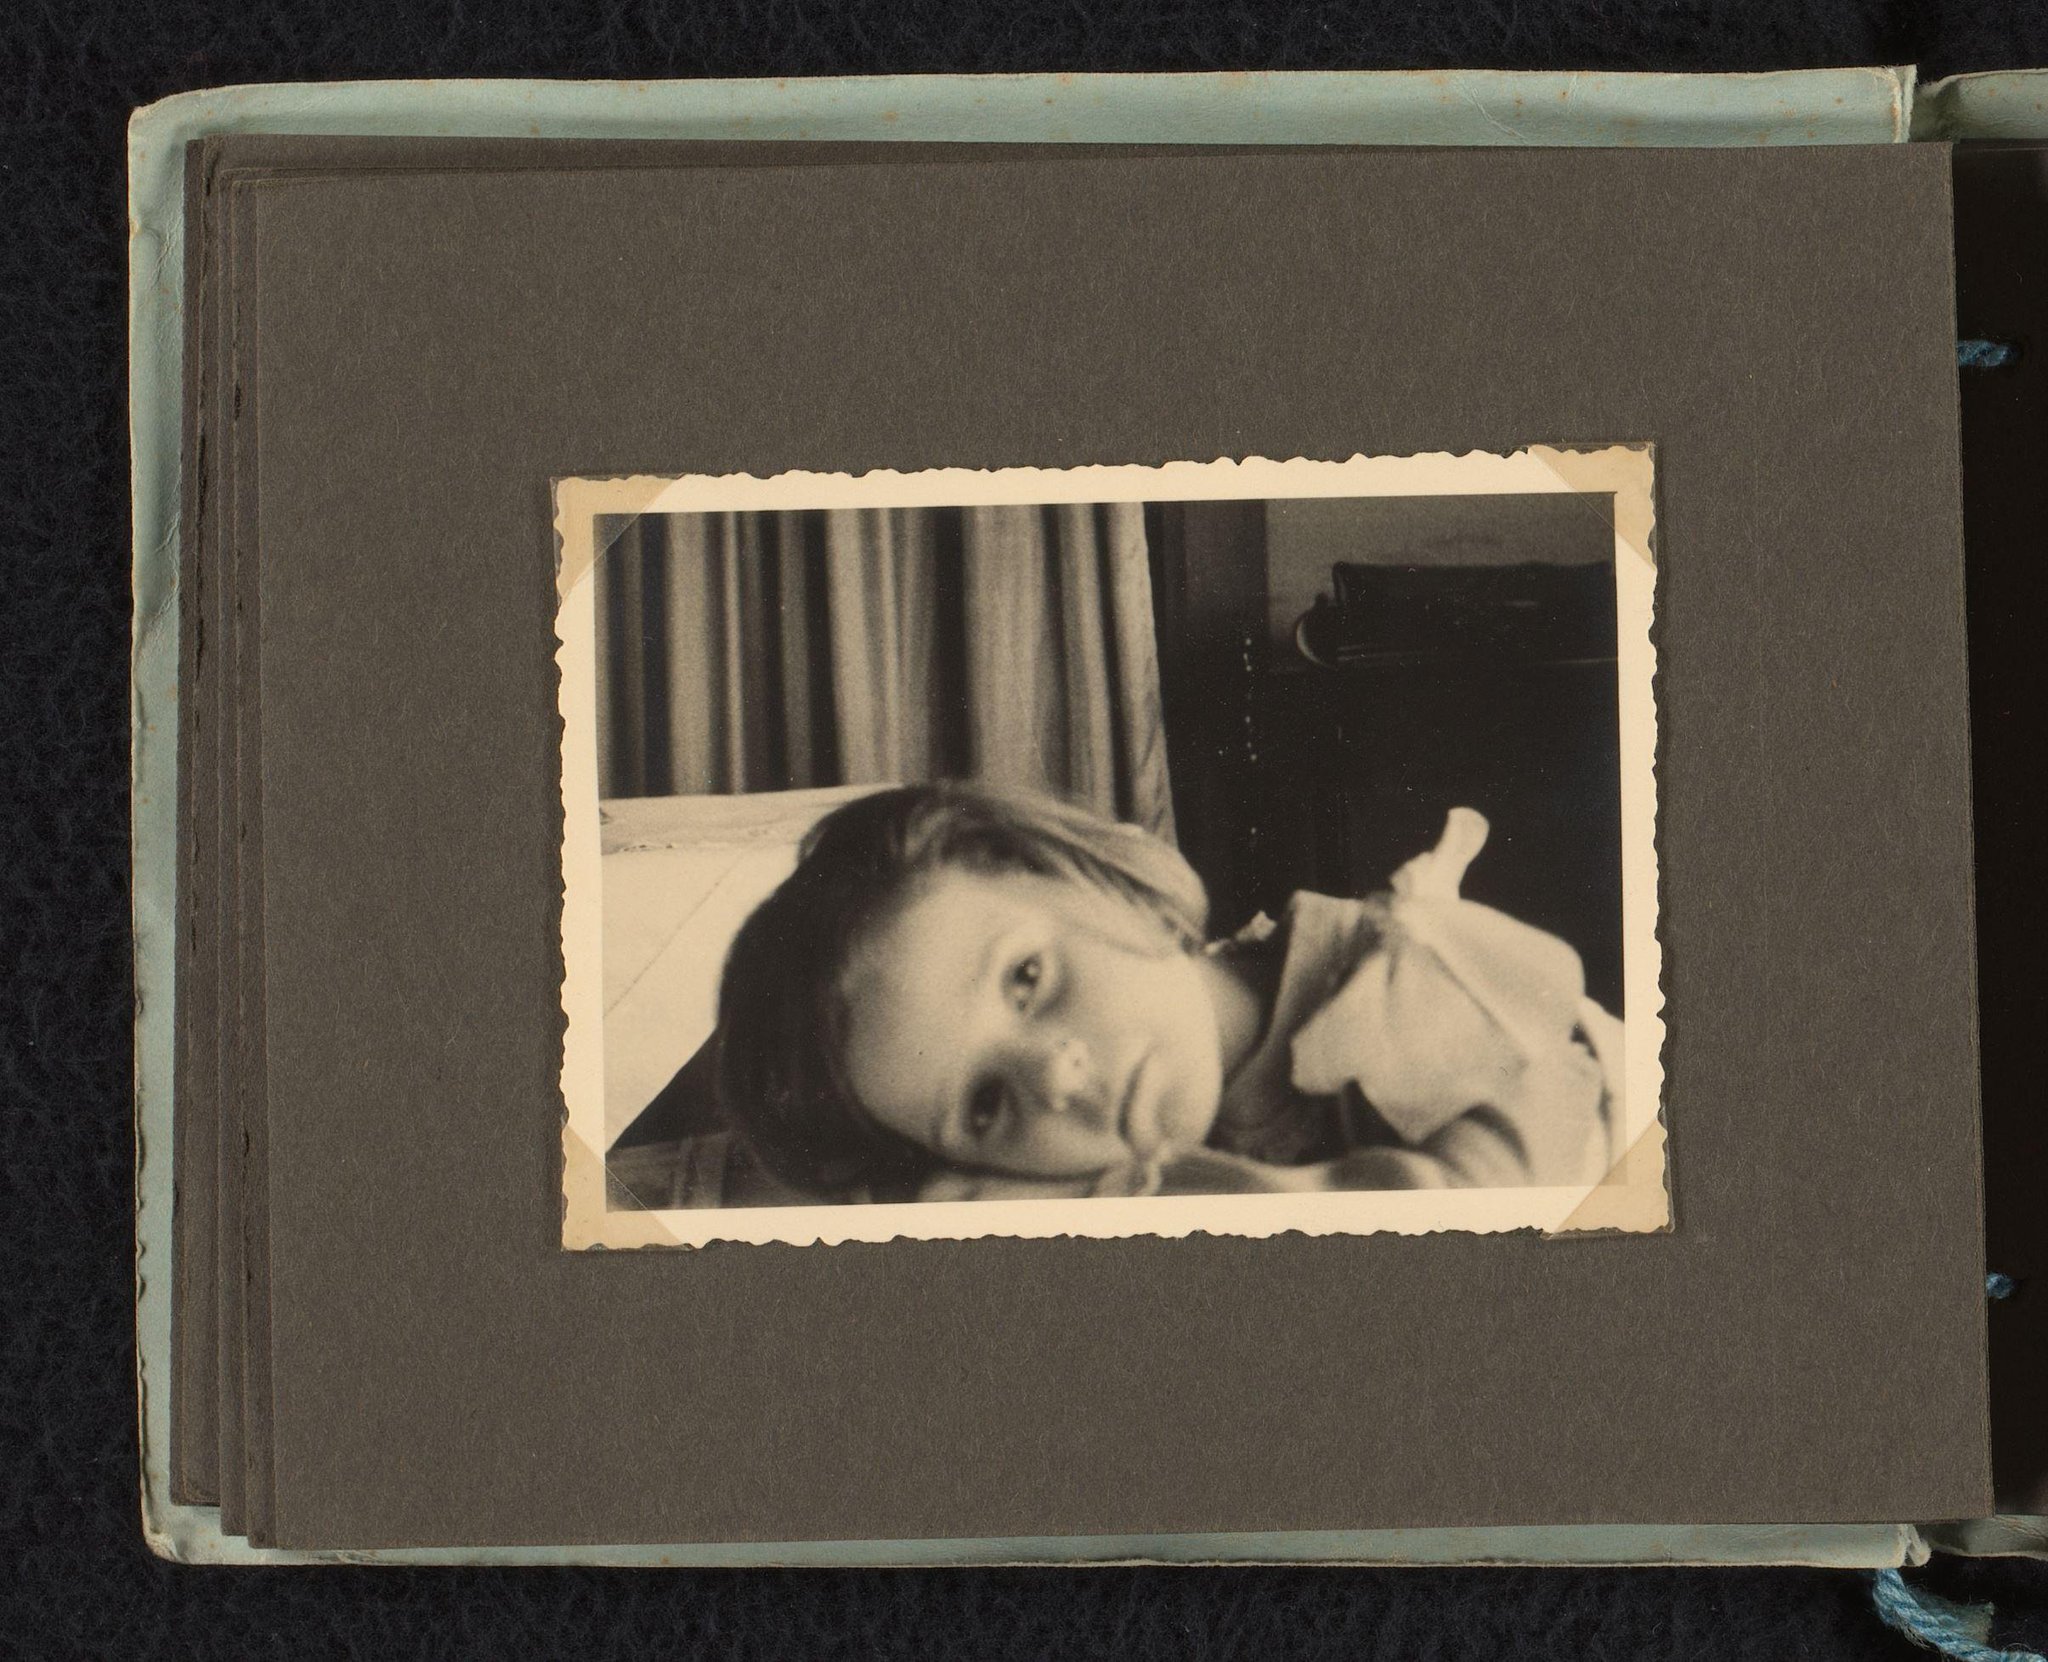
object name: album leaf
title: Isabel Wachenheimer leunt met haar hoofd op een tafel in de woning van de familie Wachenheimer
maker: else wachenheimer-moos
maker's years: 1895-1944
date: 1932-1937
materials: cardboard, photographic support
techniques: gelatin silver print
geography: stuttgart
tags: isabel wachenheimer-elon, historical persons - bb - woman, family life at home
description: Blad bevat één foto van Isabel Wachenheimer. Onderdeel van het fotoalbum 1932-1937, Stuttgart.